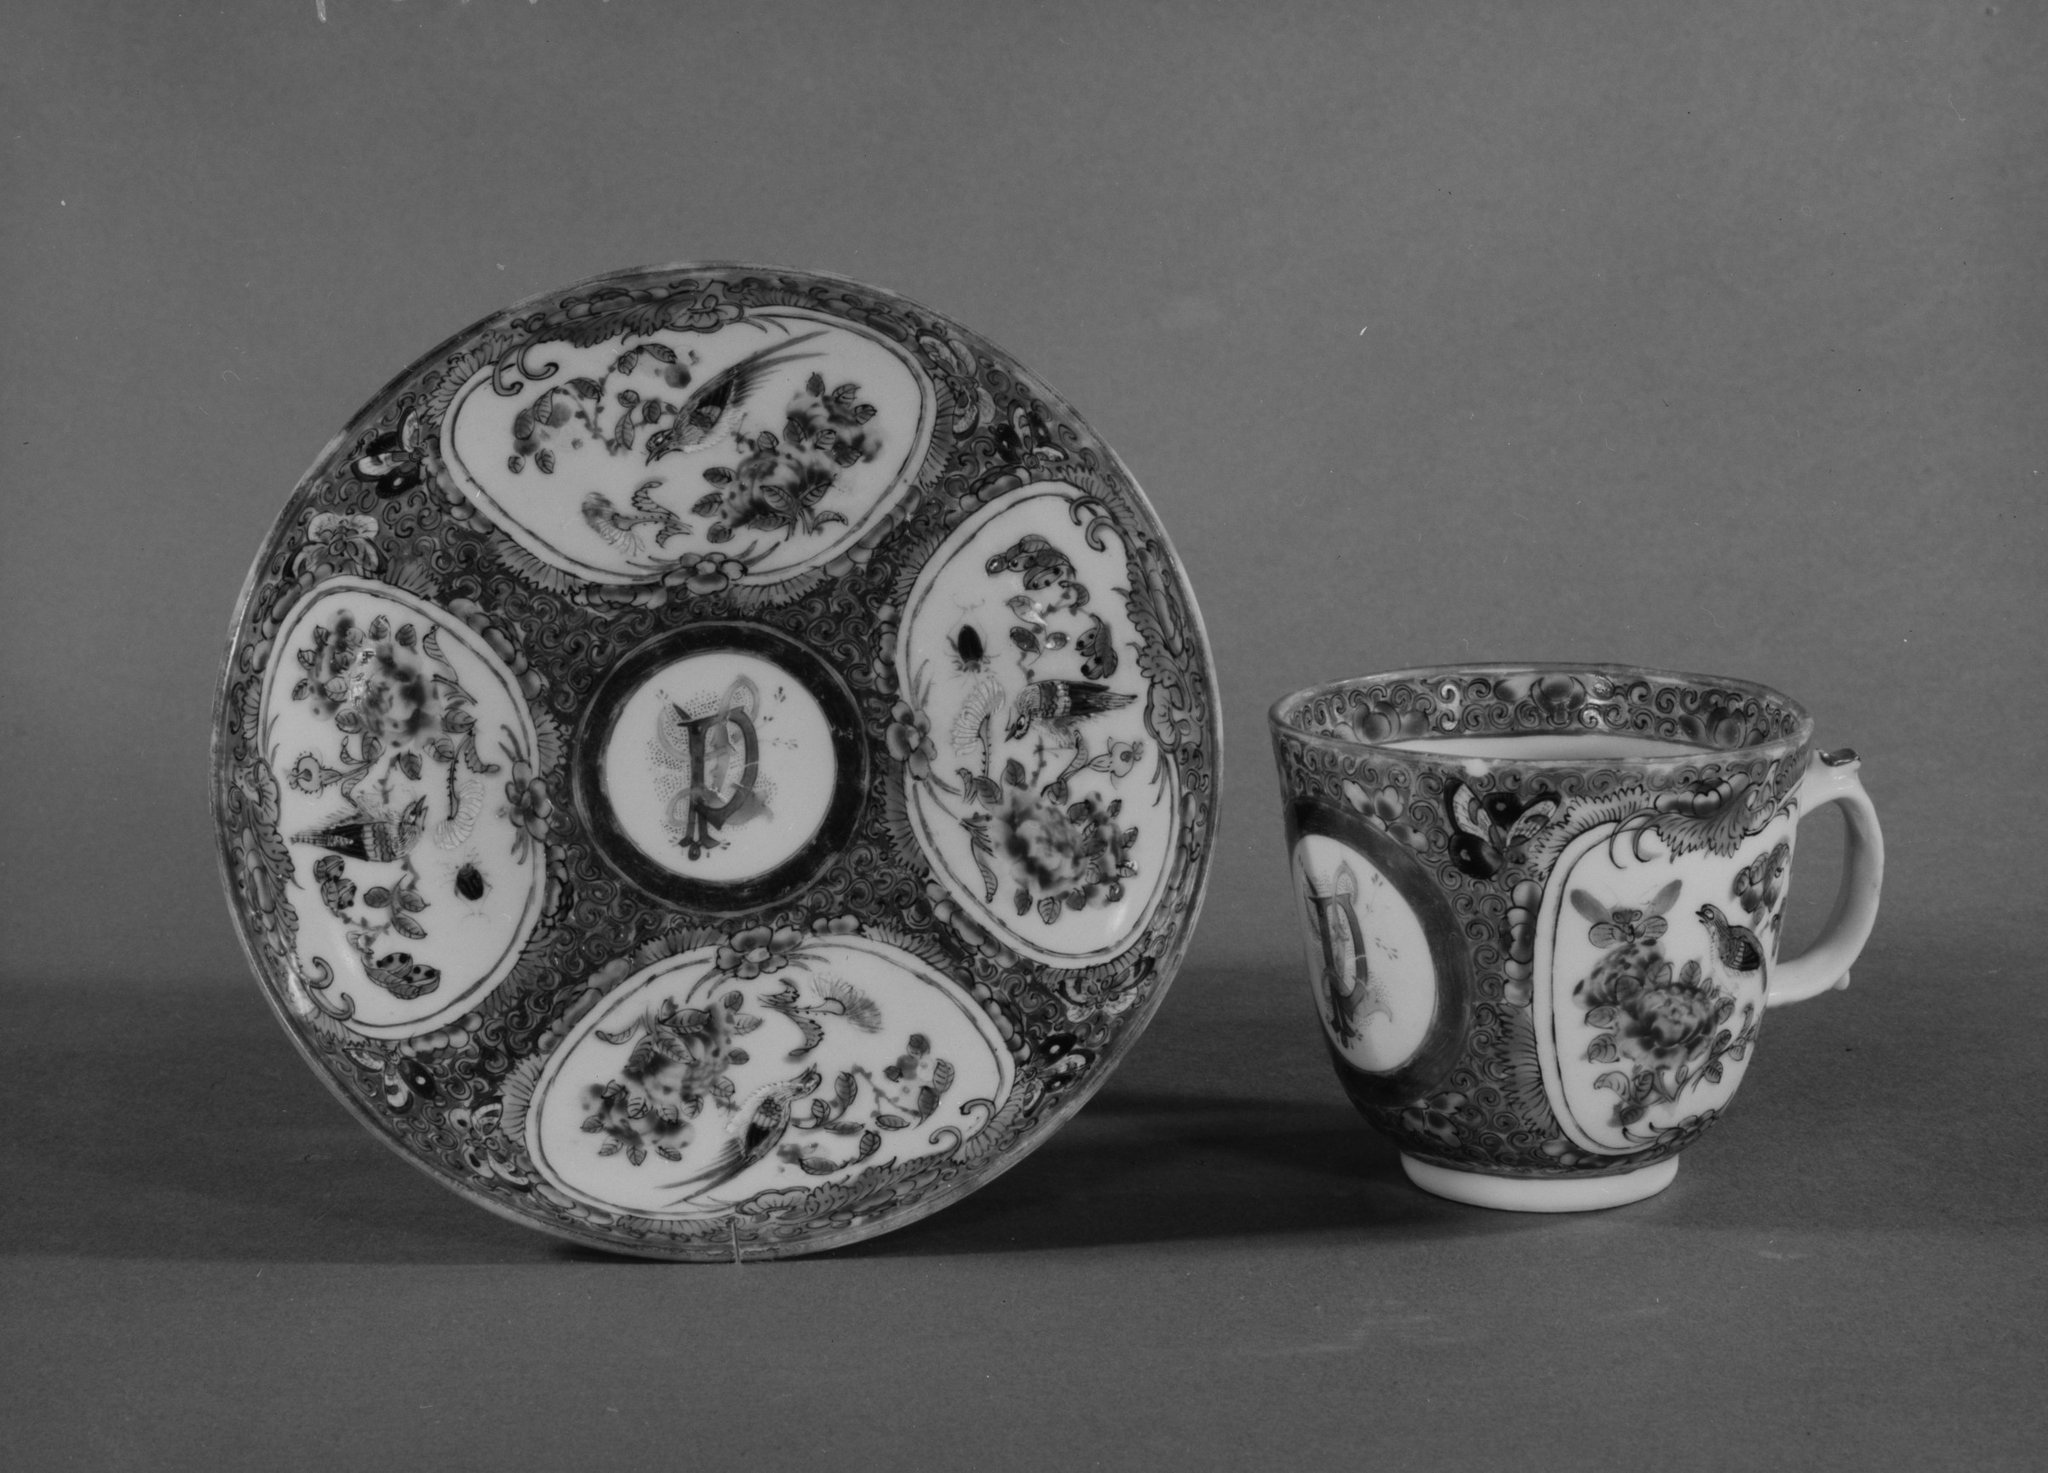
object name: cup and saucer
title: Coffee Cup and Saucer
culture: chinese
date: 1860-1866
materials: porcelain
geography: china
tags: birds,flowers